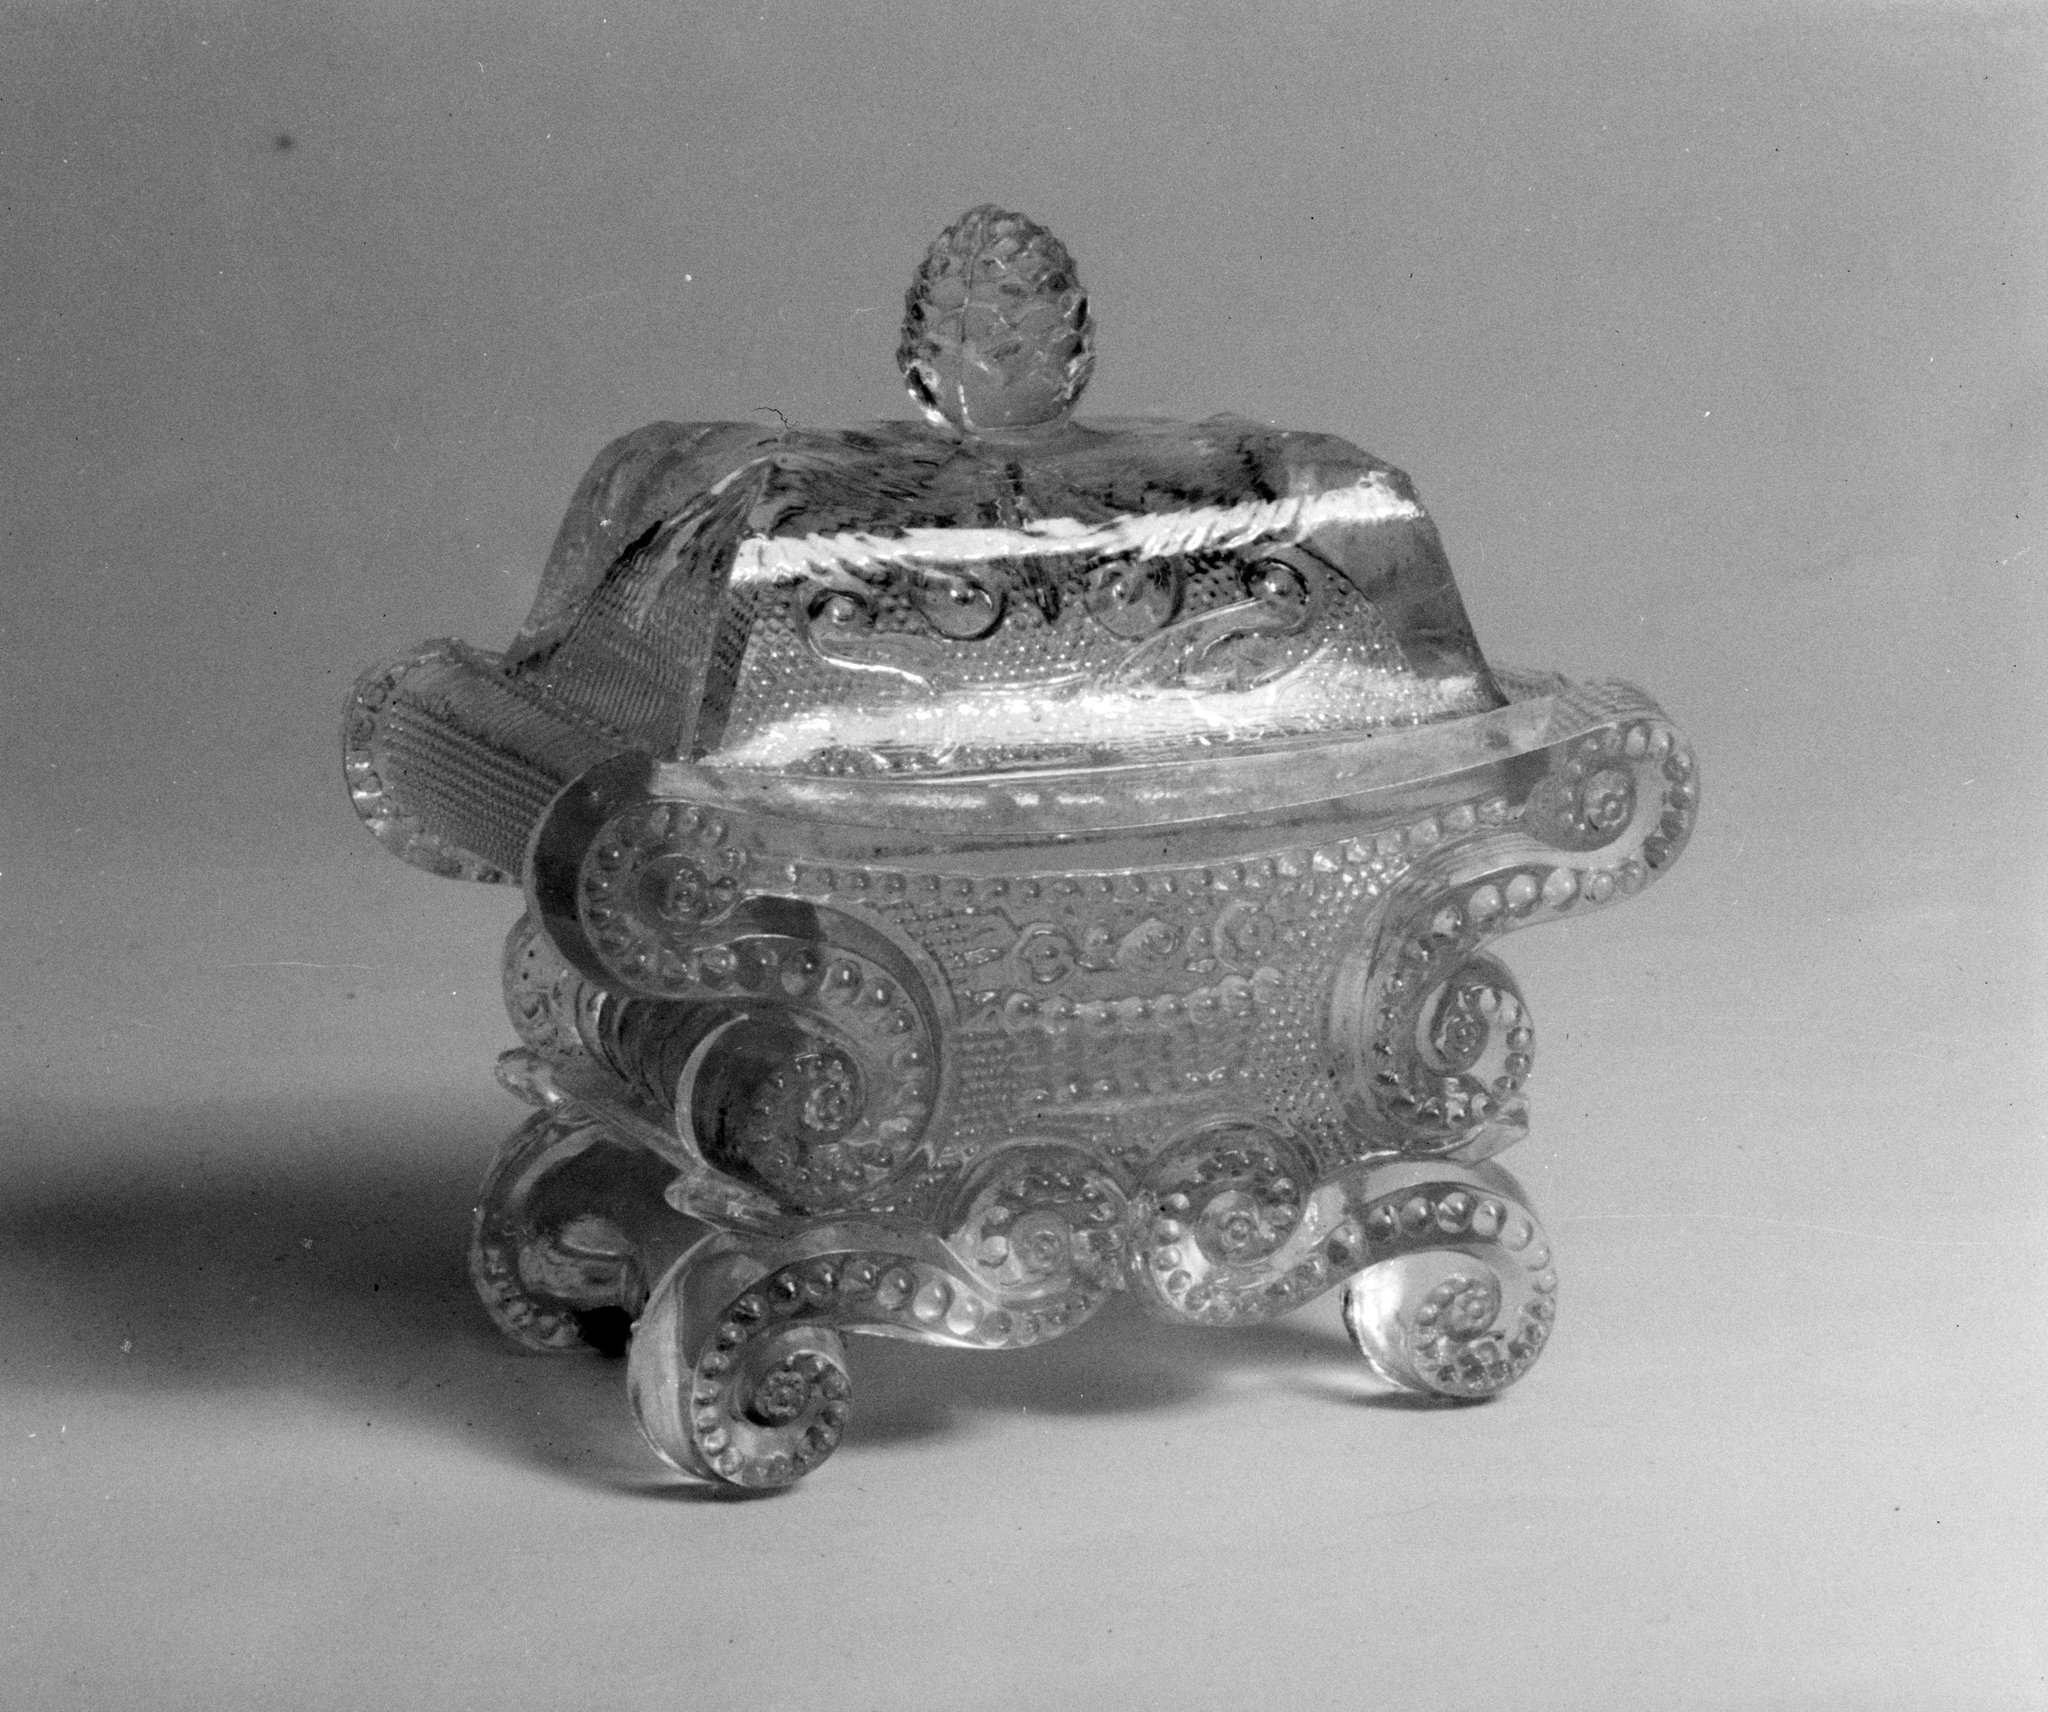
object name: salt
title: Covered Salt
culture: american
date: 1830-1840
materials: glass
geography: united states